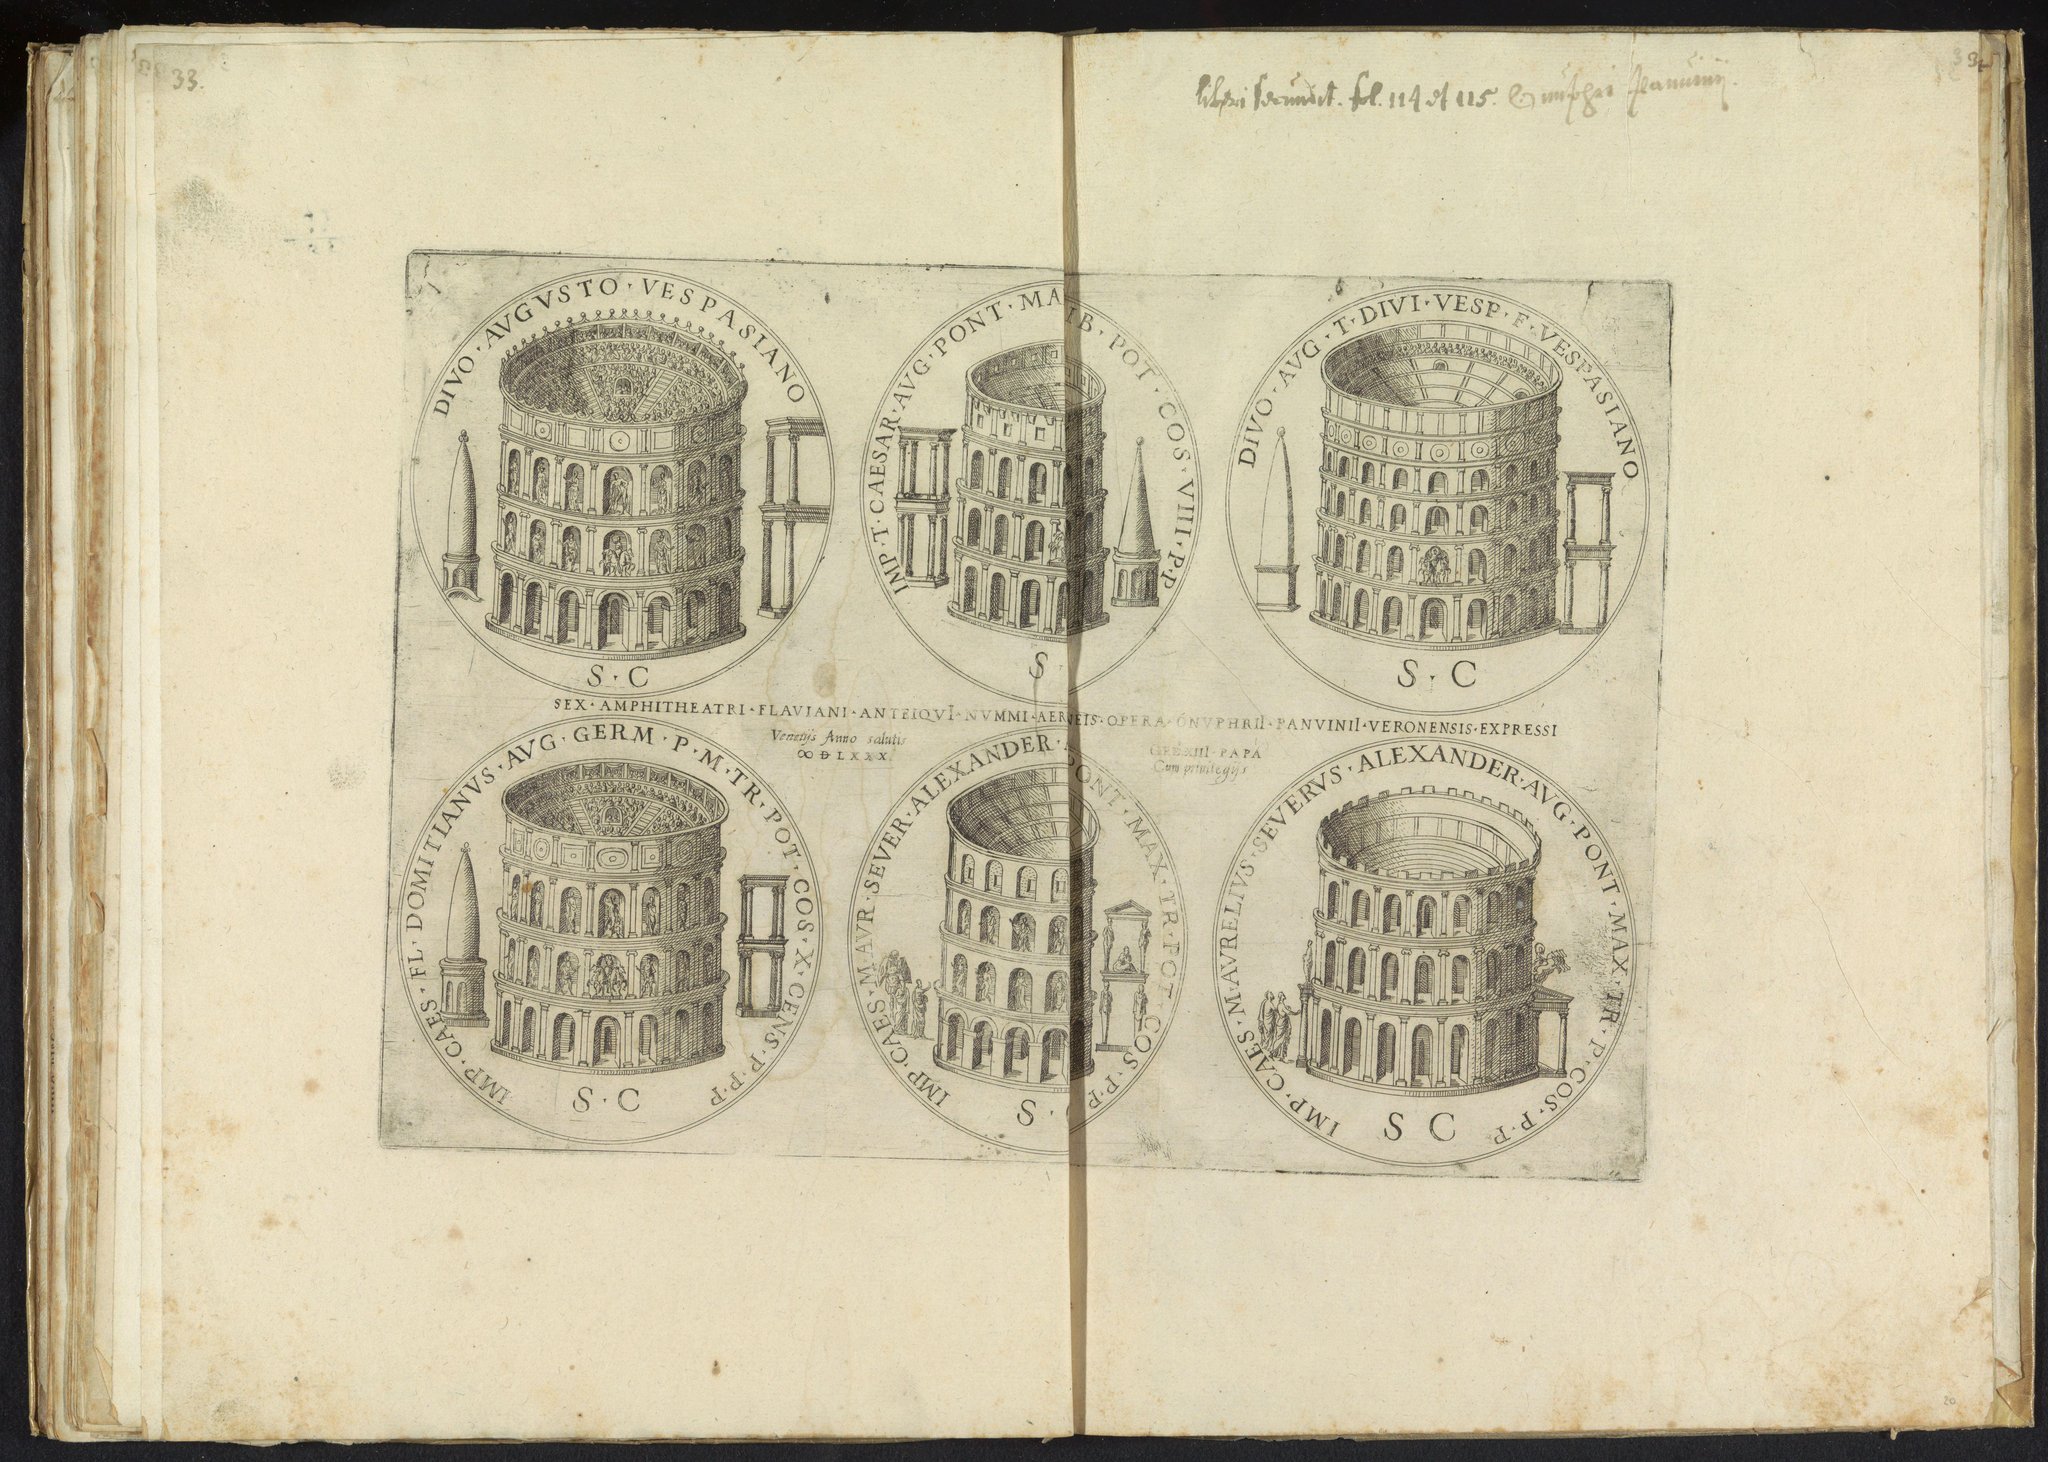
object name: print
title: Zes penningen met amfitheaters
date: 1580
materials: paper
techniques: etching, intaglio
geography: italy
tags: wagon racing with two-wheeled vehicle, e.g.: chariot, sulky, buildings for performances, charioteer, 'auriga', coin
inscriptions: inscription: ‘libri [...] fol. 114 - 115 [...]’, number: ‘33’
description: Twee rijen van drie penningen met amfitheaters. In het midden en op de penningen tekst in het Latijn. Prent maakt deel uit van een album.